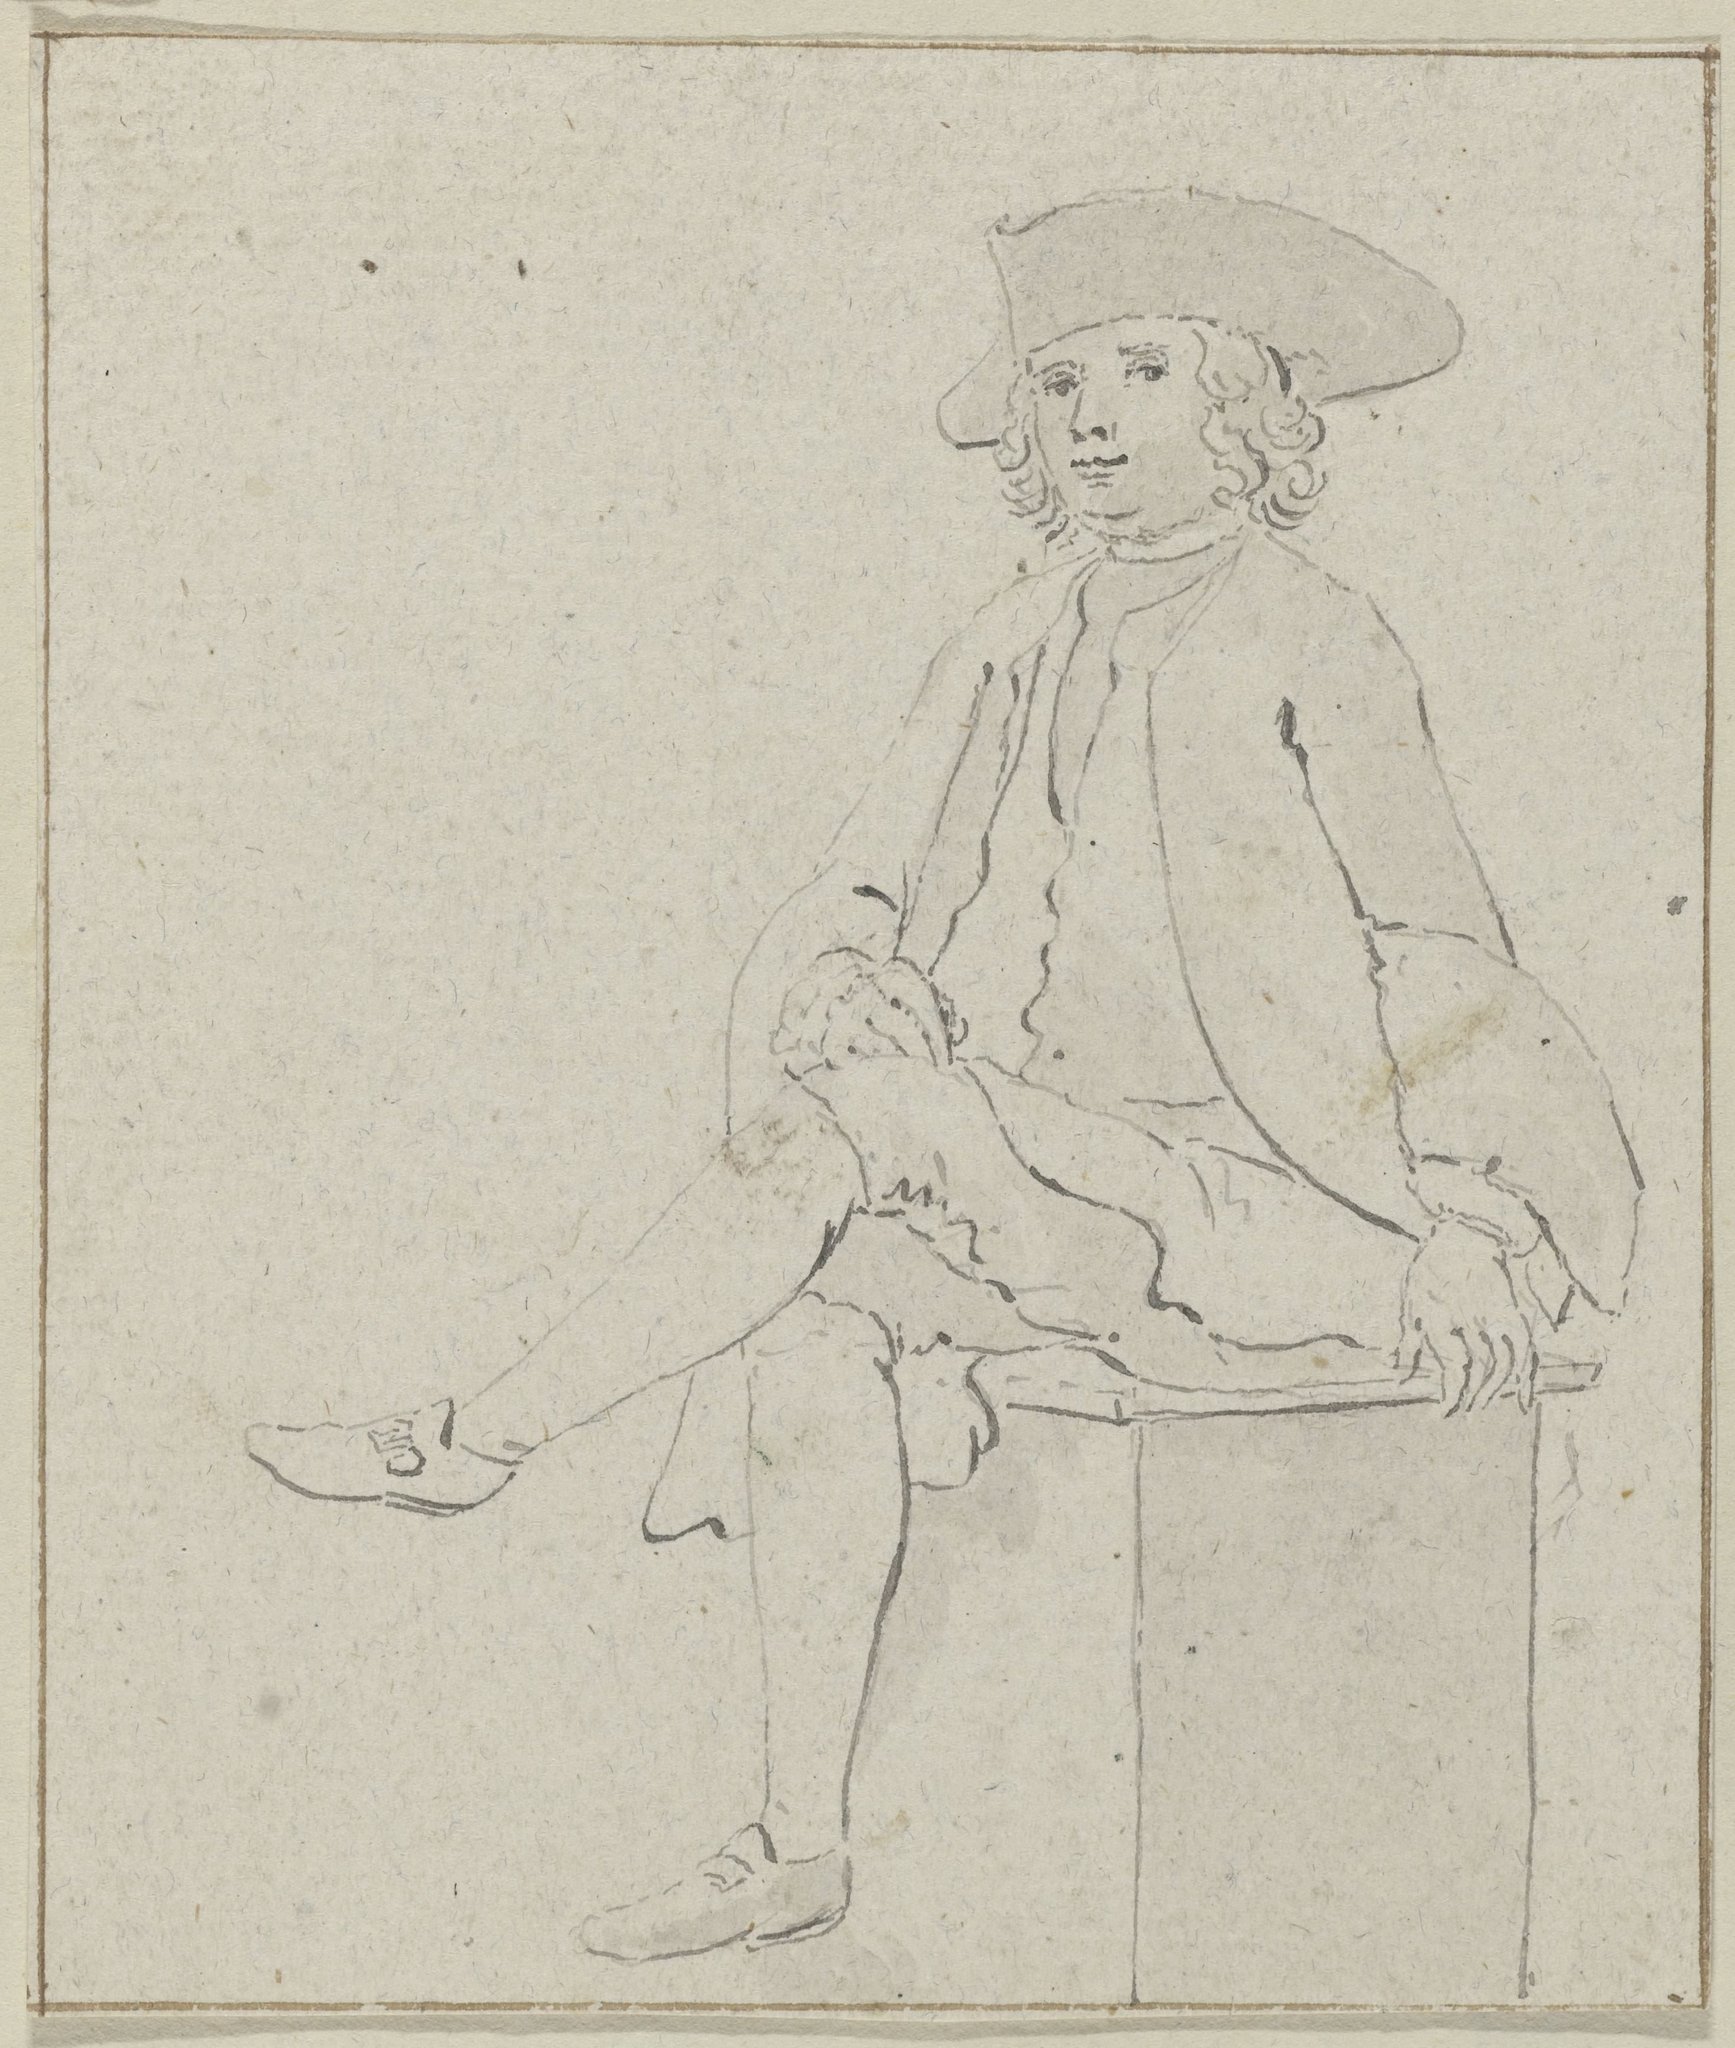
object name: drawing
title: Zittende jongeman met steek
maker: Anonymous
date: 1700-1799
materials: ink, paper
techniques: brush, pen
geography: netherlands